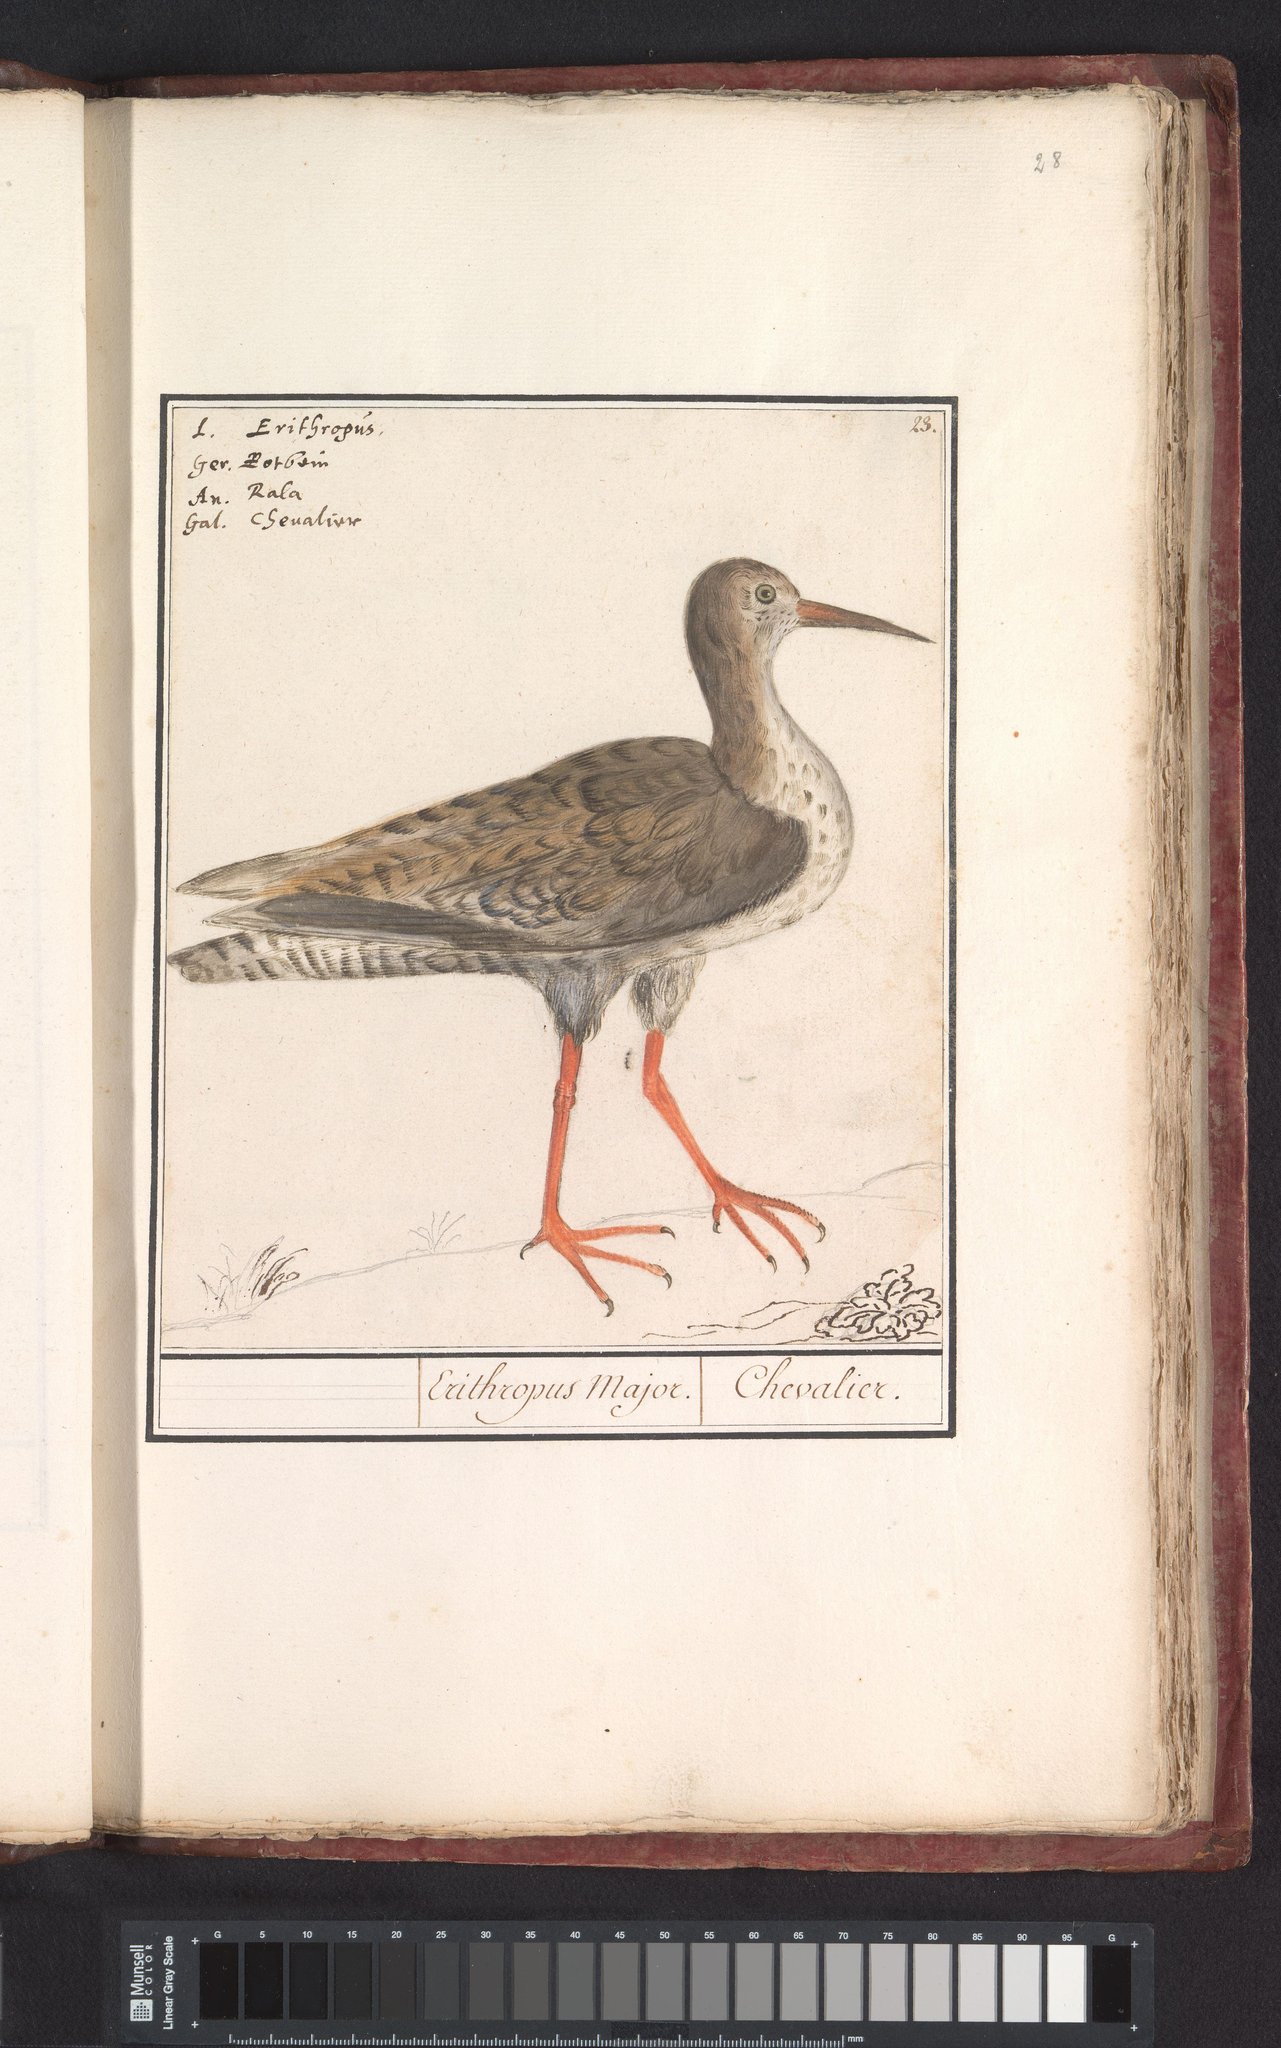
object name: drawing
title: Erithropus Major. / Chevalier.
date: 1596-1610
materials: chalk, paint, ink, paper, pencil, watercolor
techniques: brush, pen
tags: shore-birds and wading-birds: redshank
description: Tureluur. Genummerd rechtsboven: 23. Linksboven de naam in vier talen. Onderdeel van het derde album met tekeningen van vogels. Vijfde van twaalf albums met tekeningen van dieren, vogels en planten bekend rond 1600, gemaakt in opdracht van keizer Rudolf II. Met toelichting in Nederlands, Latijn en Frans.